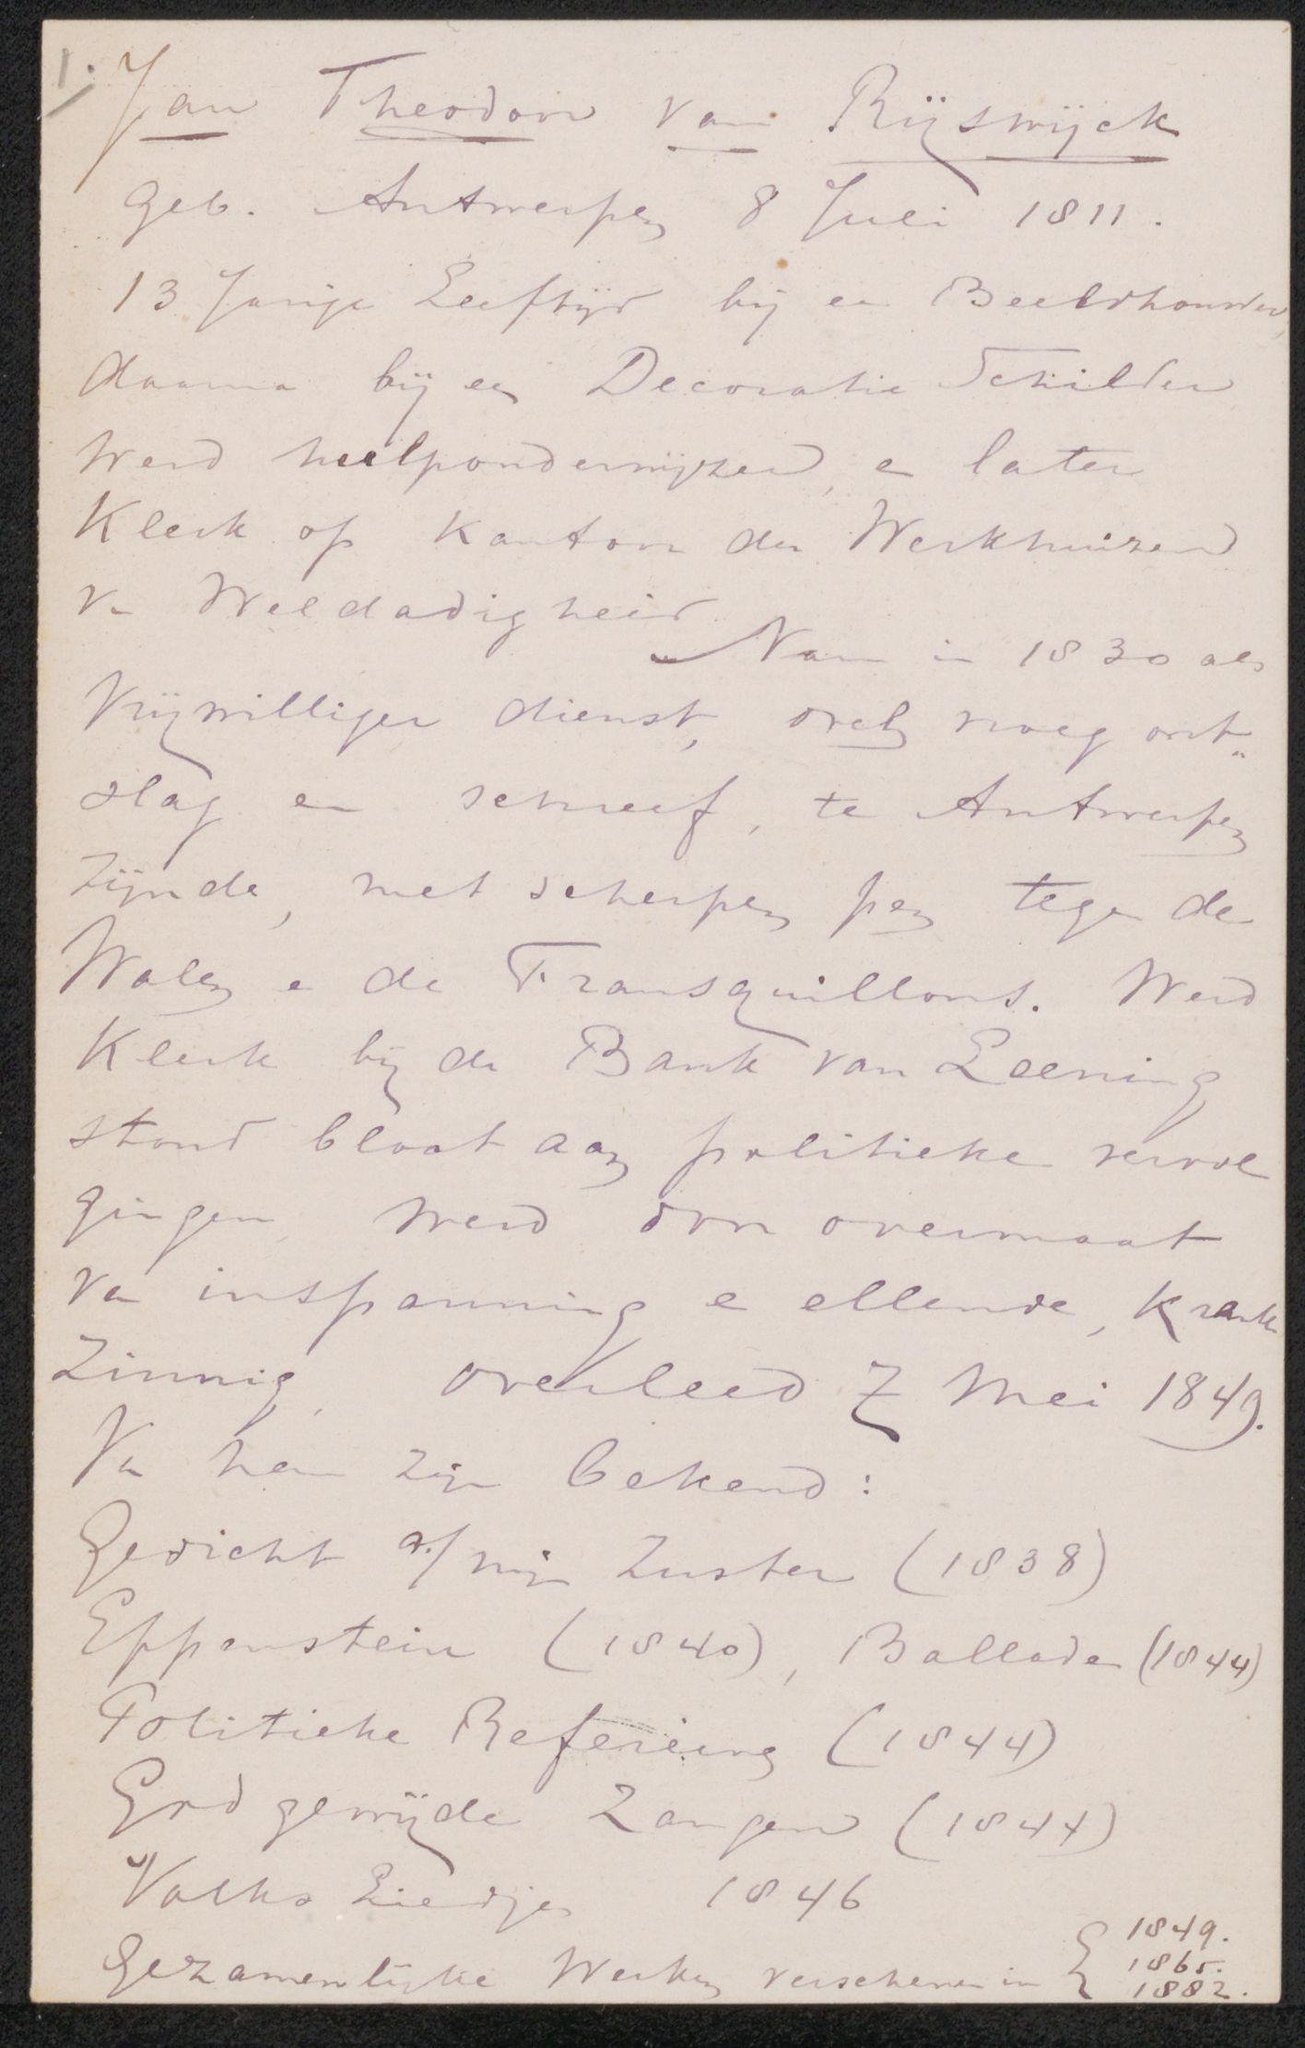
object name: tekst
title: Tekst betreffende Theodor Van Ryswyck, Jan Baptist van Rijswijck en Lambert van Rijswijck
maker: Anonymous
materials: ink, paper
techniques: pen, writing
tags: antwerp, print maker, theodor van ryswyck, literature ~ arts, sculpture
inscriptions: collector's mark: Lugt 2228